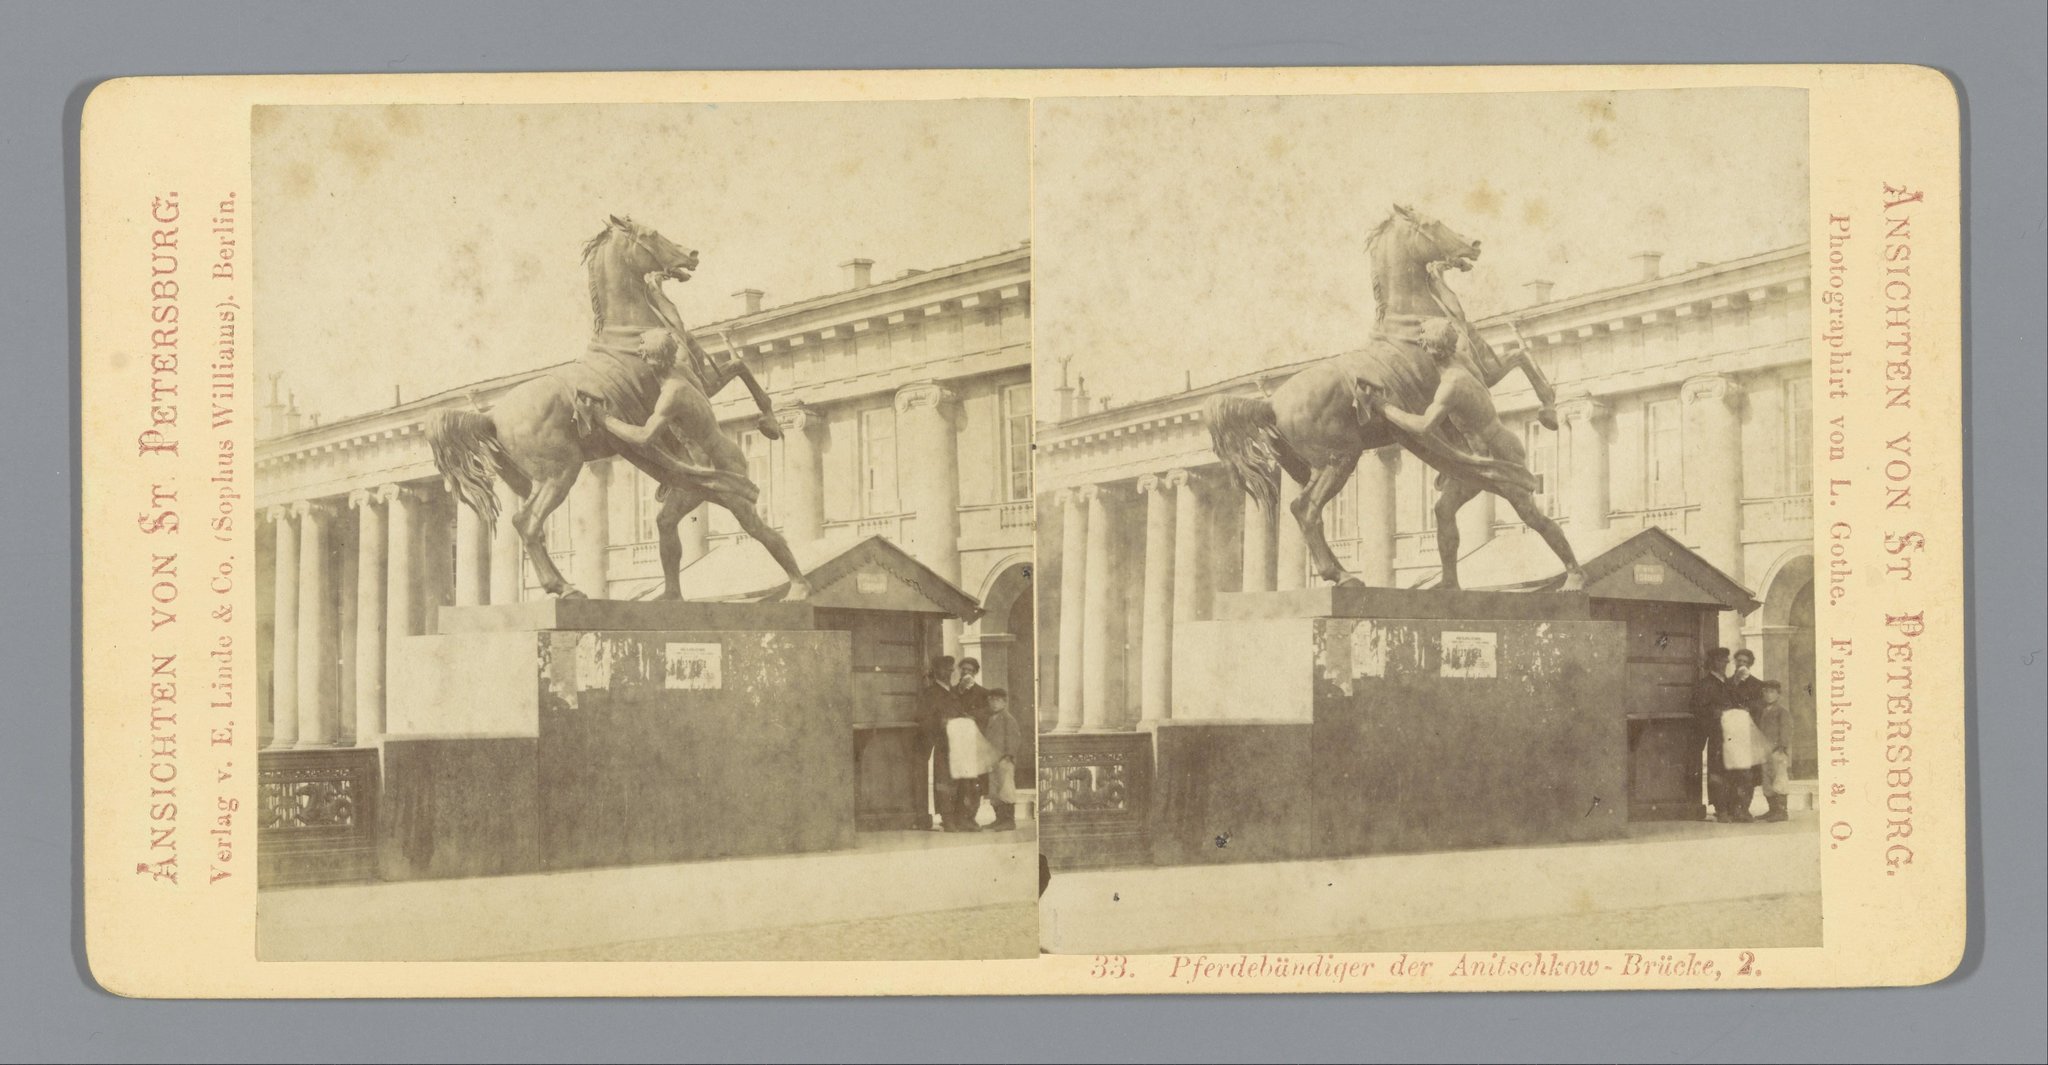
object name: stereograph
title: Sculptuur van een paardentemmer op Anichkovbrug in Sint-Petersburg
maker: louis gothe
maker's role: fotograaf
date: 1850-1880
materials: cardboard, photographic support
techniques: albumen print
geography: sint-petersburg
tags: piece of sculpture, reproduction of a piece of sculpture, bridge in city across river, canal, etc.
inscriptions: number: ‘33.’, inscription: ‘Ansichten von St. Petersburg.’